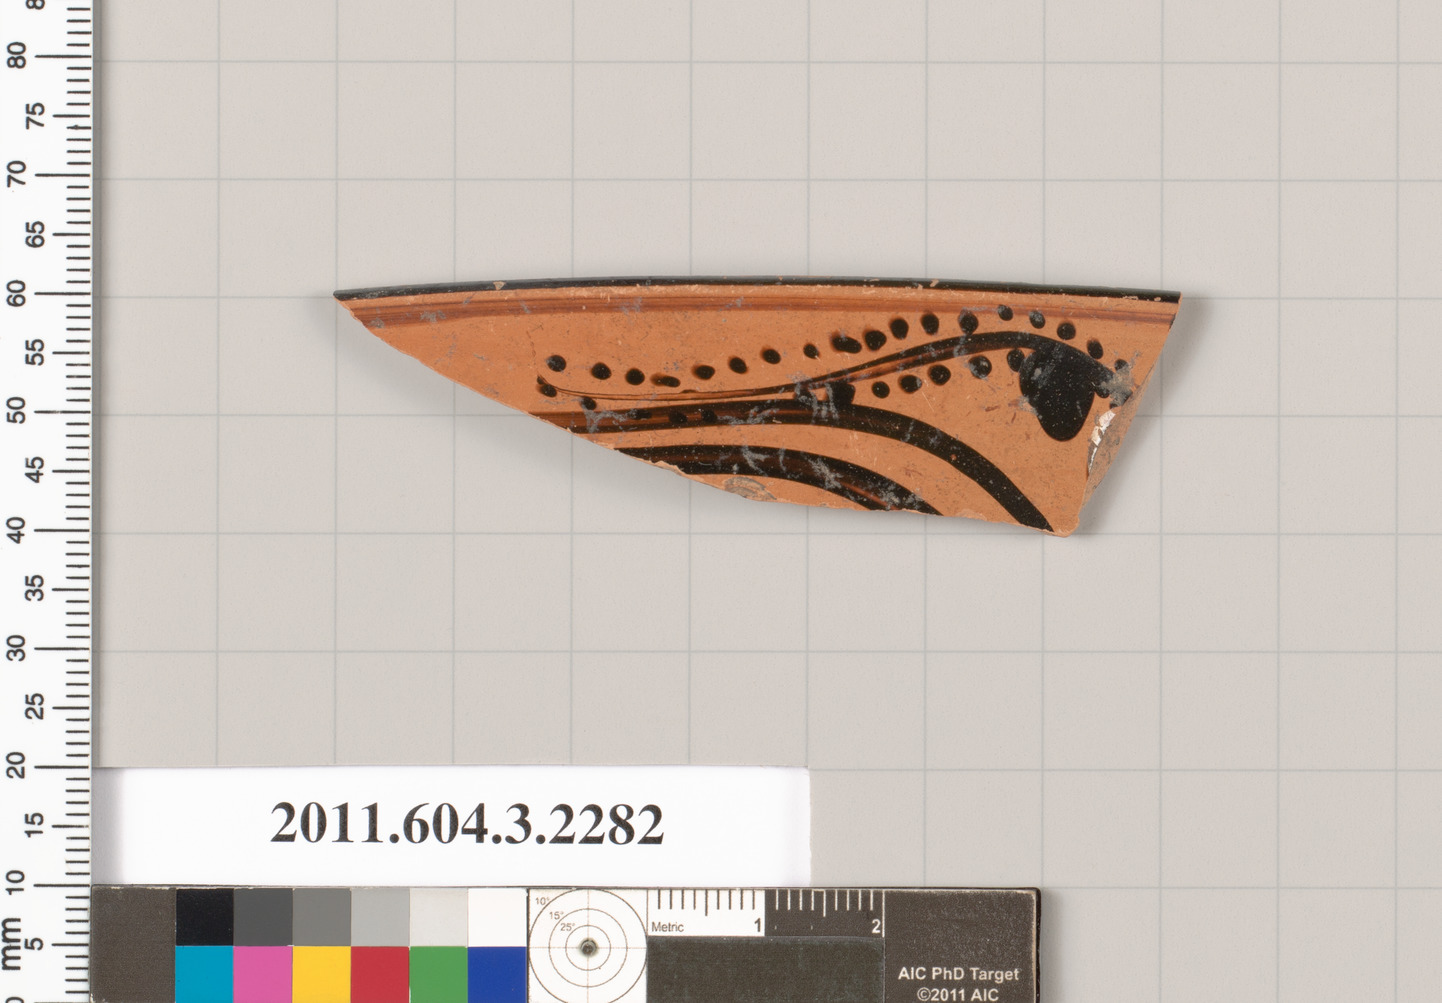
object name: kylix fragment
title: Terracotta rim fragment of a kylix: eye-cup (drinking cup)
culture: greek, attic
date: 525-501 BCE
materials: terracotta